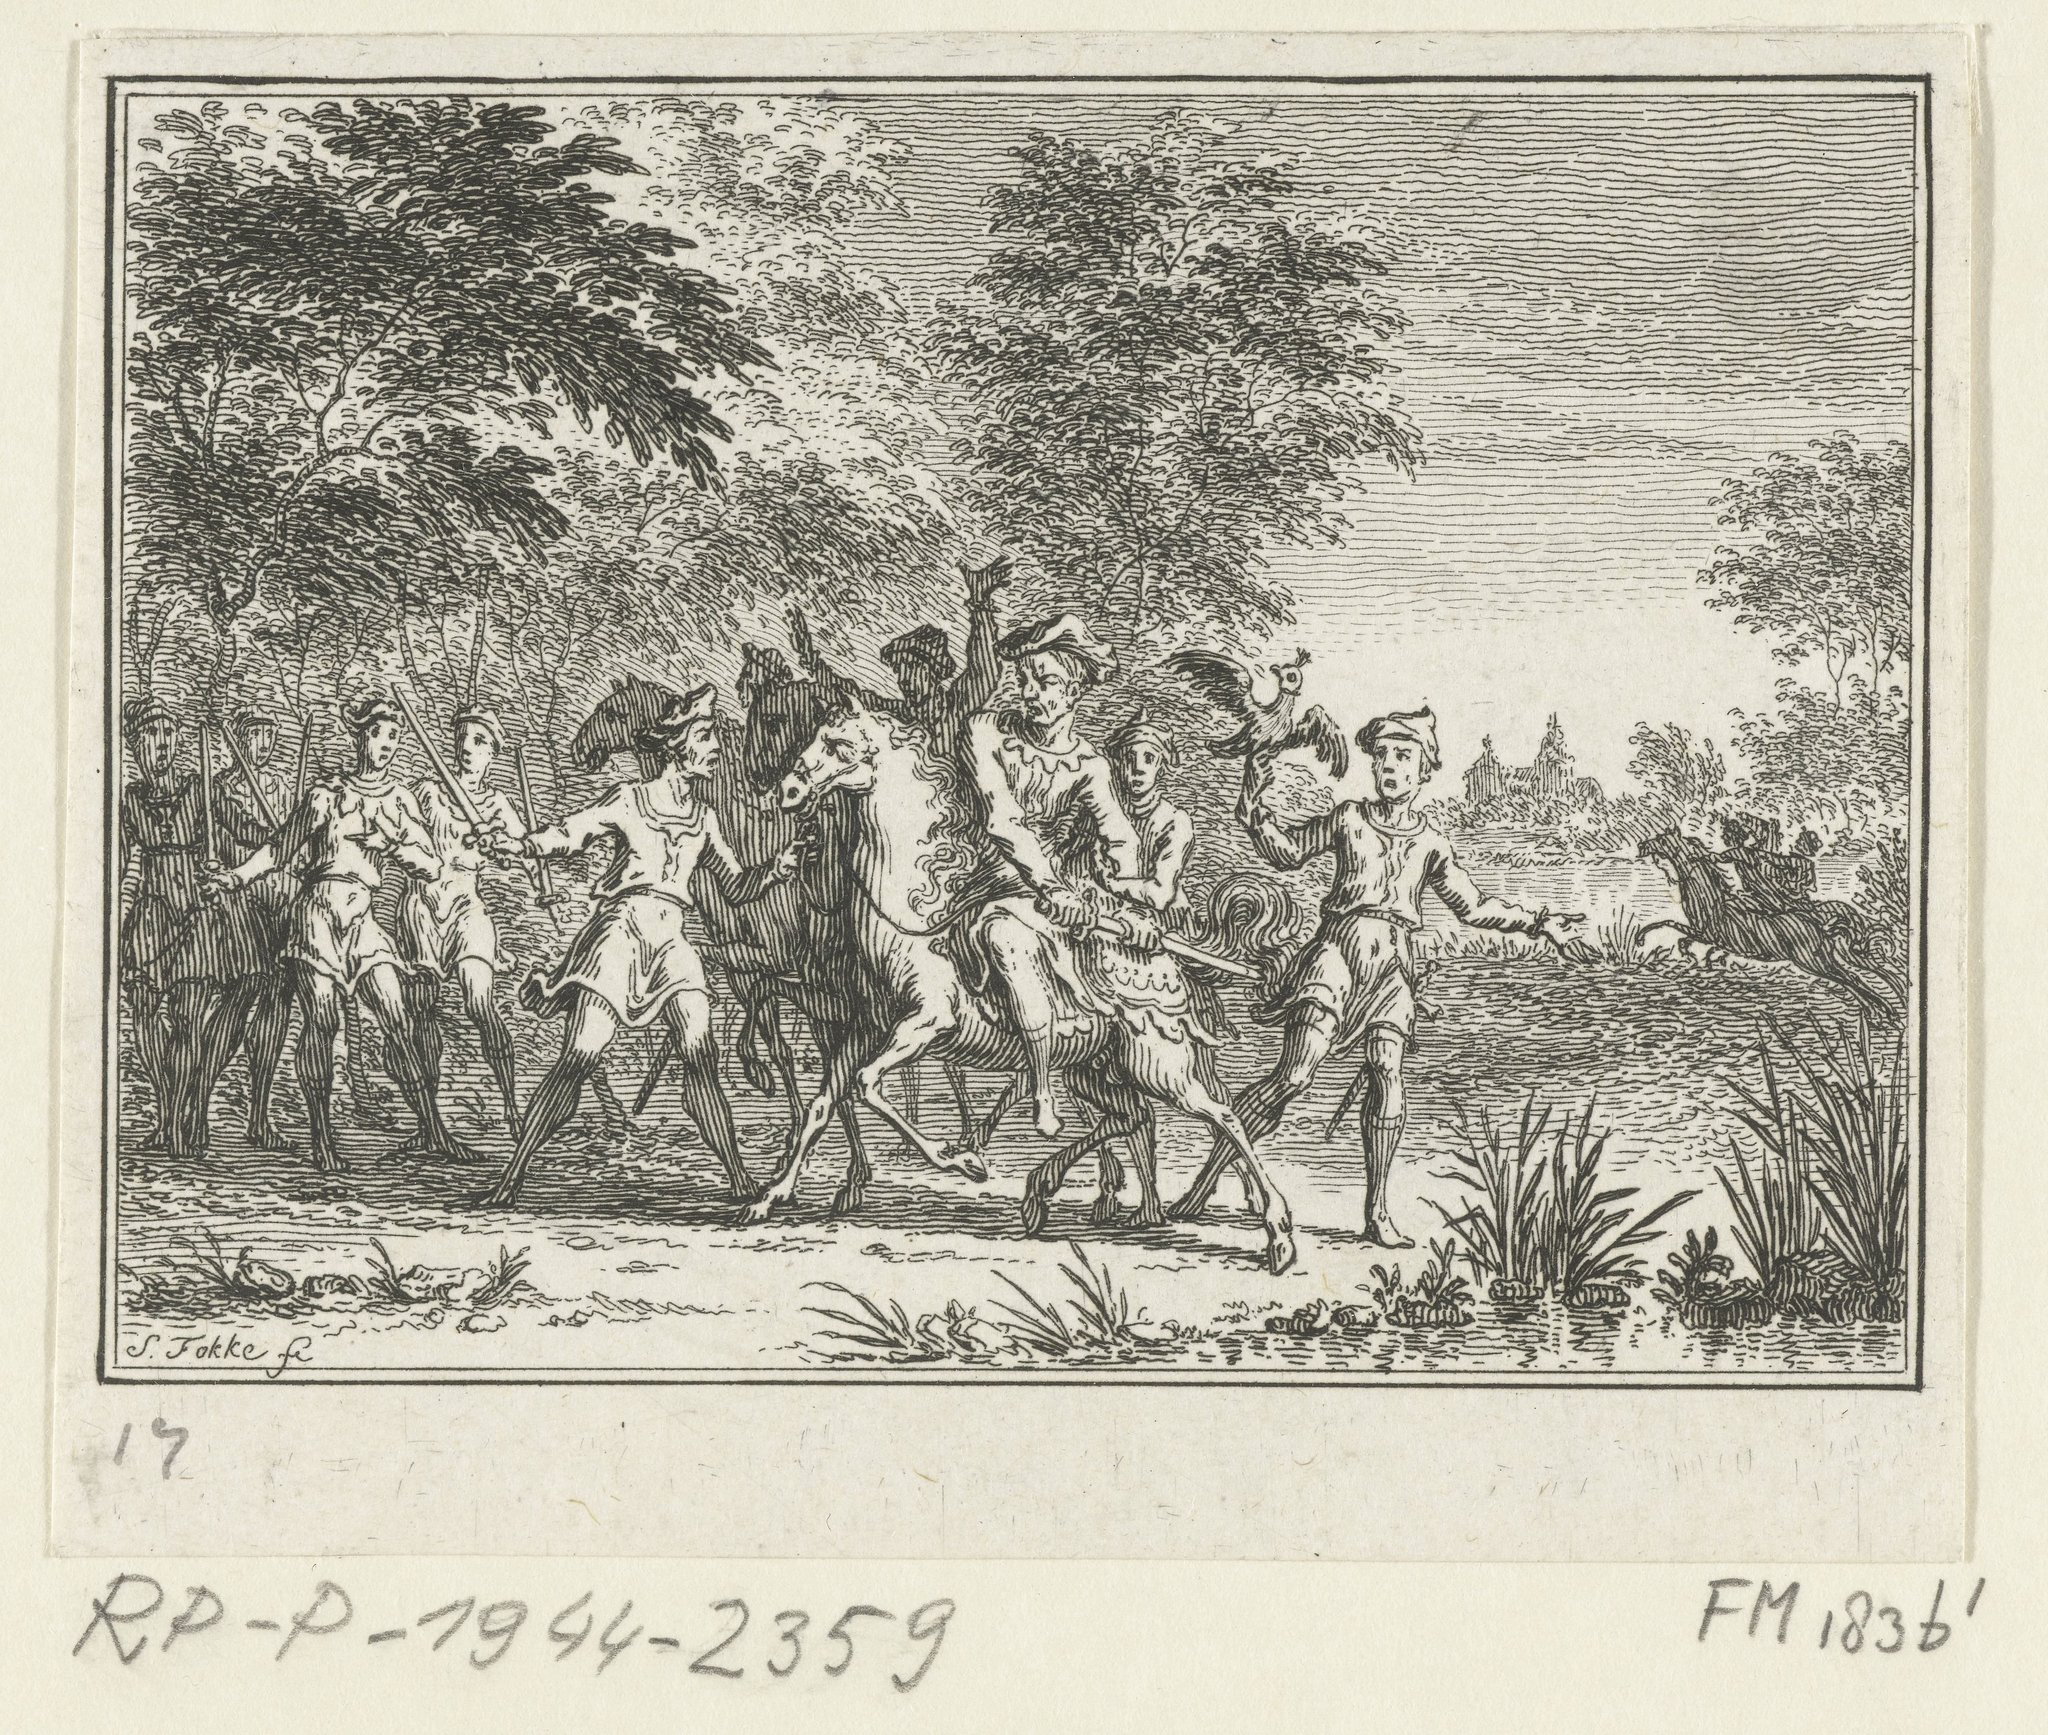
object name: print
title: Floris V tijdens het jagen gevangengenomen, 1296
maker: simon fokke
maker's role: draughtsman, print maker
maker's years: 1712-1784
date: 1782-1784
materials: paper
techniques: etching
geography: northern netherlands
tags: leiden, floris v (graaf van holland en zeeland), sports, games ~ animals (+ hunting with falcon, hawk; falconry), netherlands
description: Illustratie voor: J.W. te Water, De vaderlandsche Historie van den heere J. Wagenaar, verkort, en met leerzaame aanmerkingen, ten dienste der Nederlandsche jeugd, 1784-1800, 4 delen, blz. 241. Staat vóór de letter.